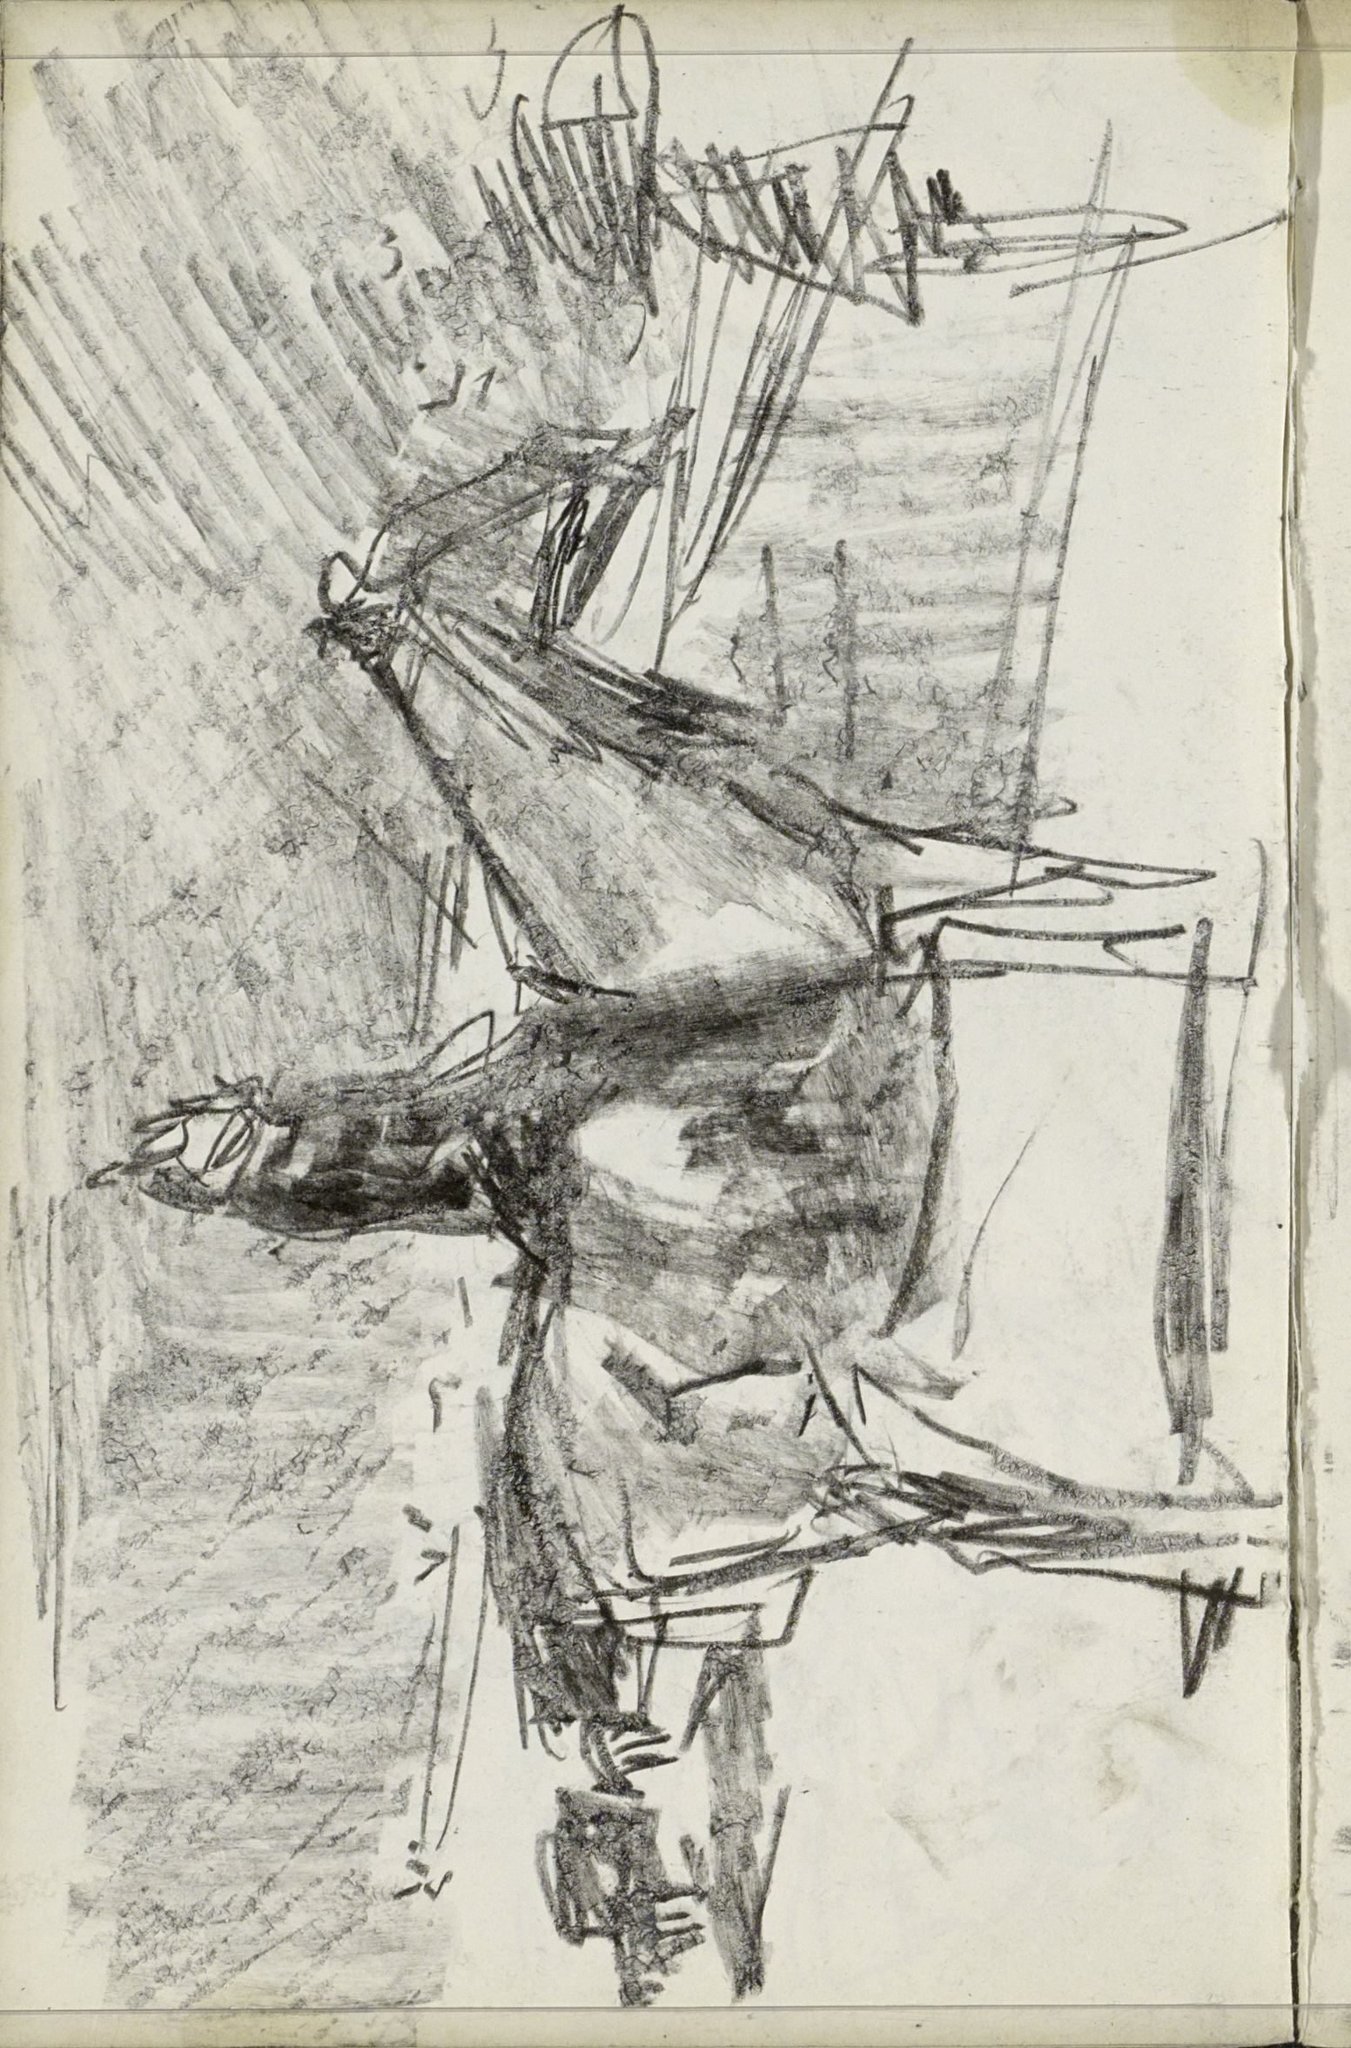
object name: sketchbook leaf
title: Ruiter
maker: isaac israels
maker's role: draughtsman, painter, print maker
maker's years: 1865-1934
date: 1875-1934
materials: chalk, paper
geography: london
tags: riding a horse, ass, or mule; rider, horseman, animal traction, animal-drawn vehicle (carriage etc.)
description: Op de achtergrond rijtuigen. Blad 10 verso uit schetsboek XXXVI met 26 bladen,